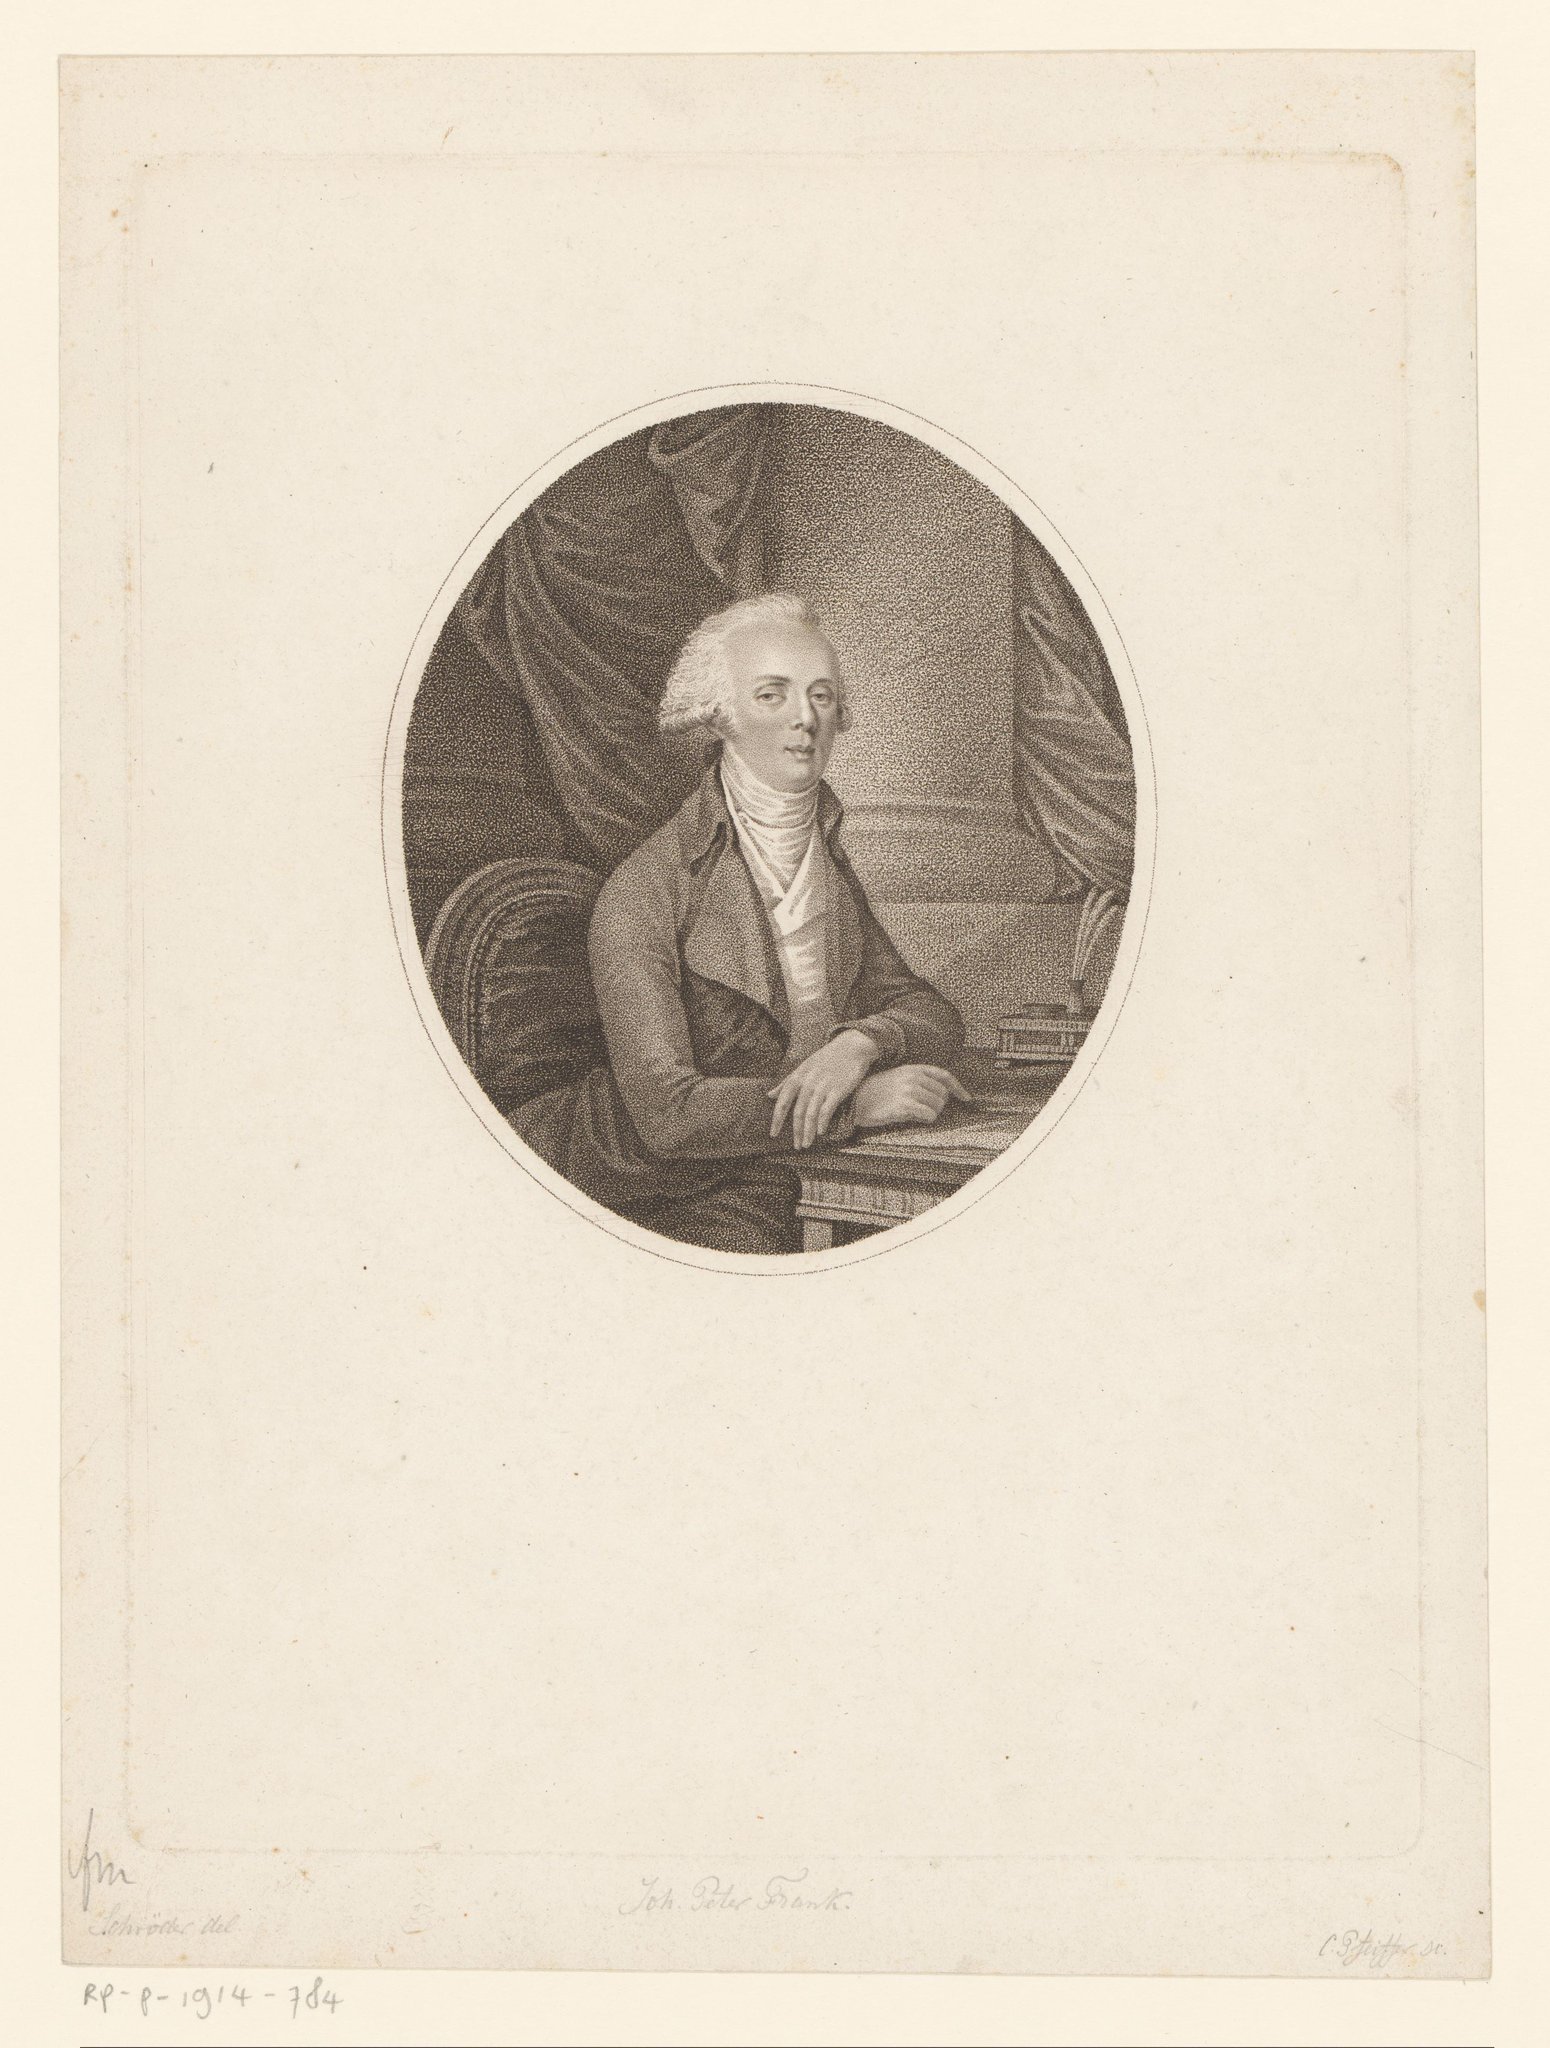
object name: print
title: Portret van Johann Peter Frank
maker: carl hermann pfeiffer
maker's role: print maker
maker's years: 1769-1829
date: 1779-1829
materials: paper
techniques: stippled etching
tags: historical persons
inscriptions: collector's mark: Lugt 2228